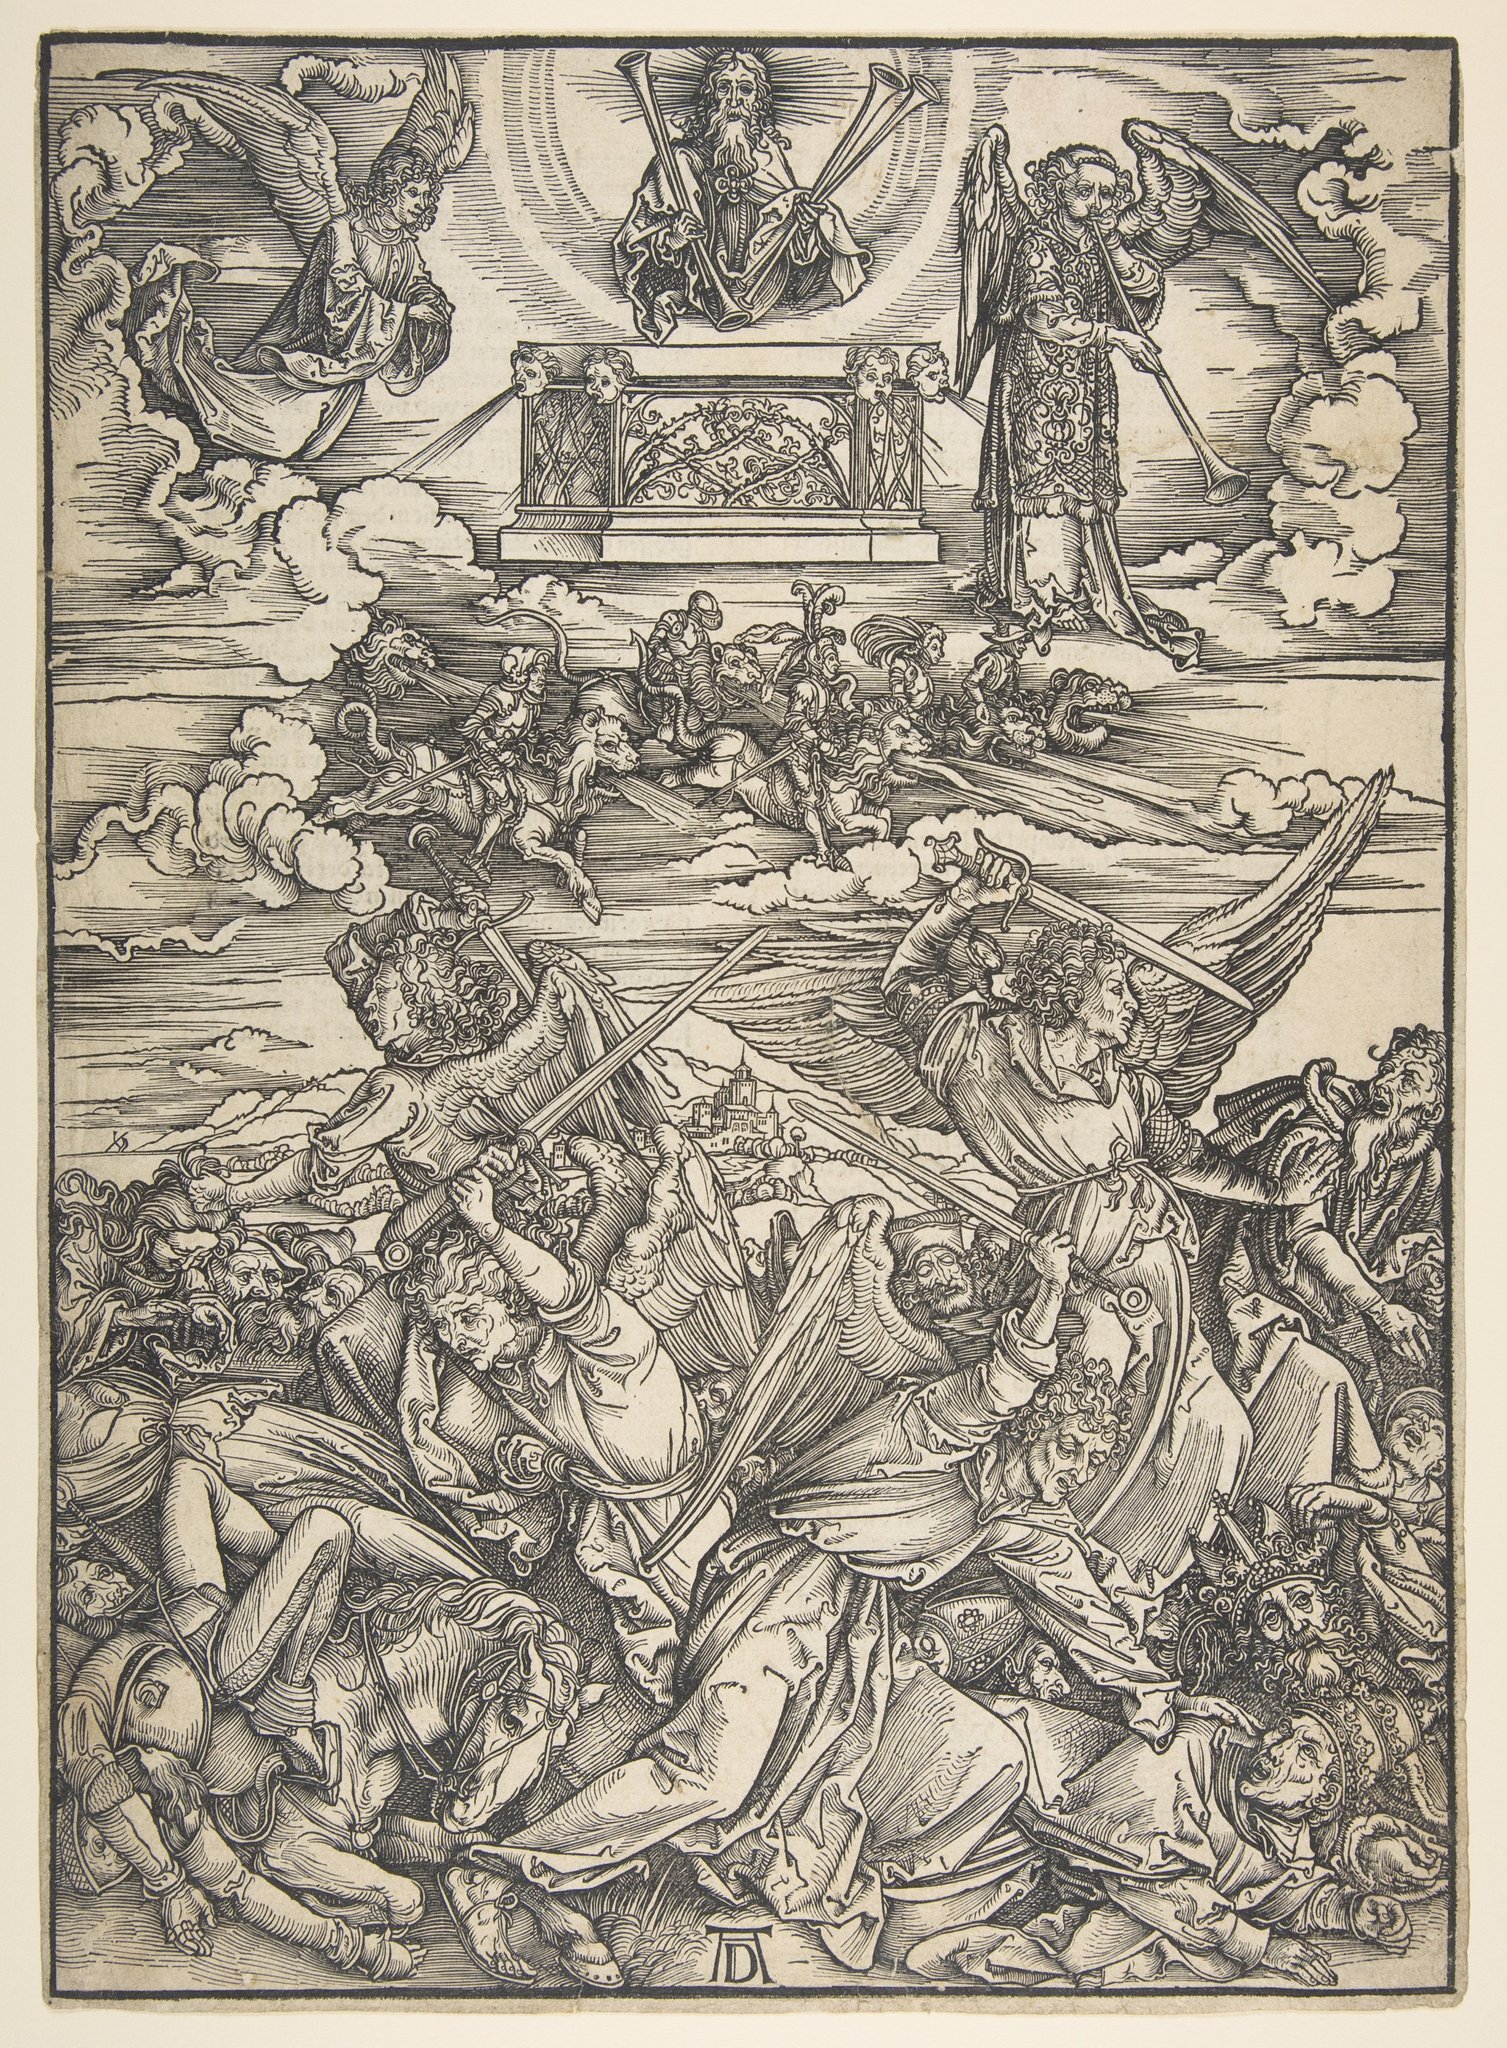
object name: print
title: Four Avenging Angels, from "The Apocalypse"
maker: albrecht dürer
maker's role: artist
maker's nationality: german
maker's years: 1471-1528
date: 1497-1498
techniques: woodcut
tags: animals,swords,angels,apocalypse